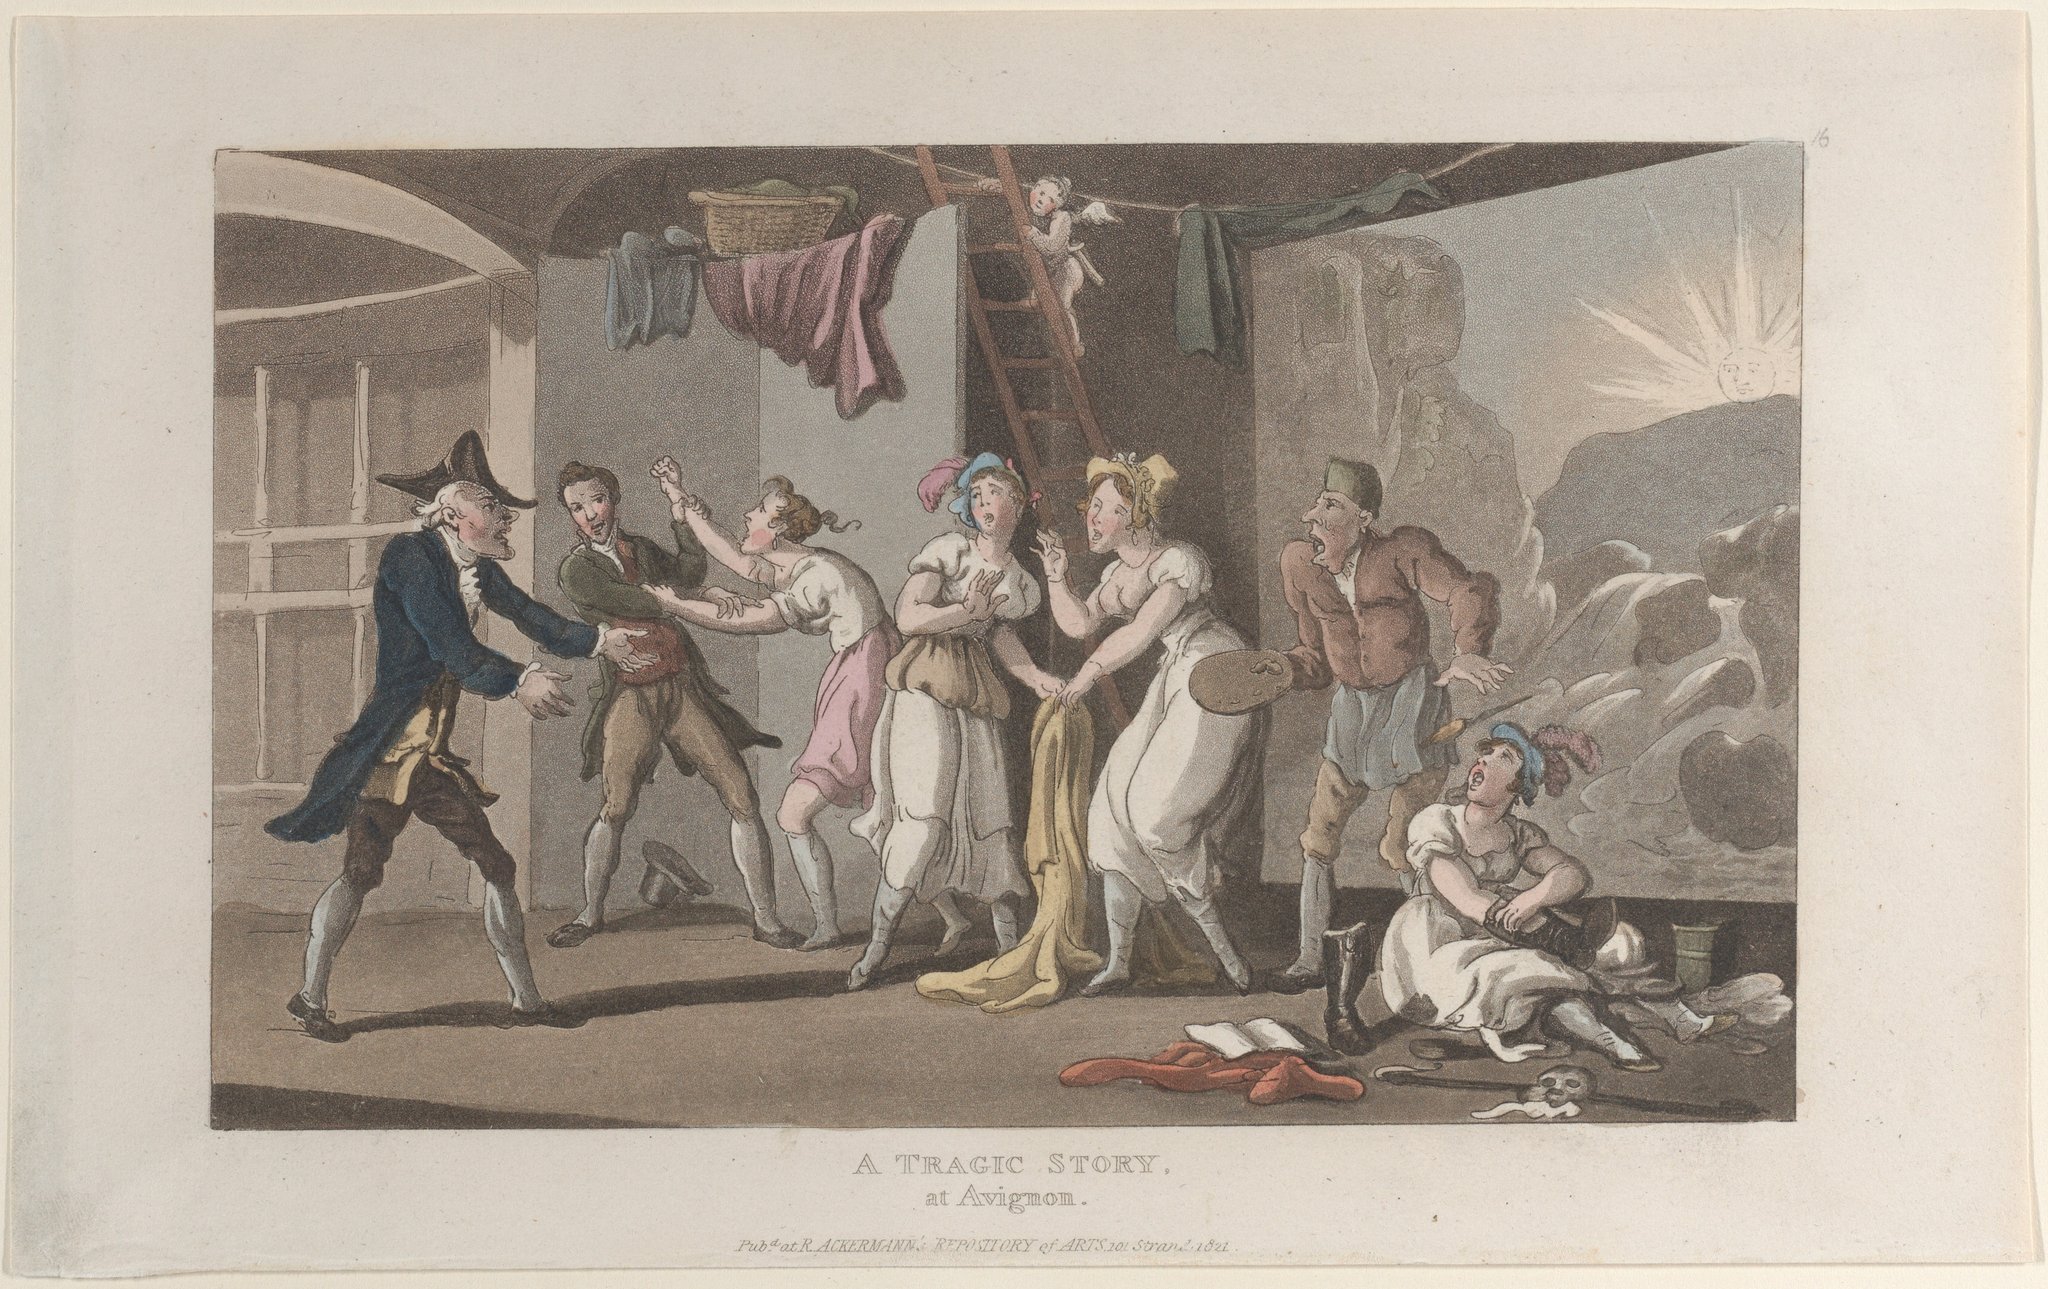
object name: print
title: A Tragic Story at Avignon, from "Journal of Sentimental Travels in the Southern Provinces of France, Shortly Before the Revolution"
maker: thomas rowlandson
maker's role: artist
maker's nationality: british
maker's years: 1757-1827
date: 1821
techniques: aquatint, etching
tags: men,women